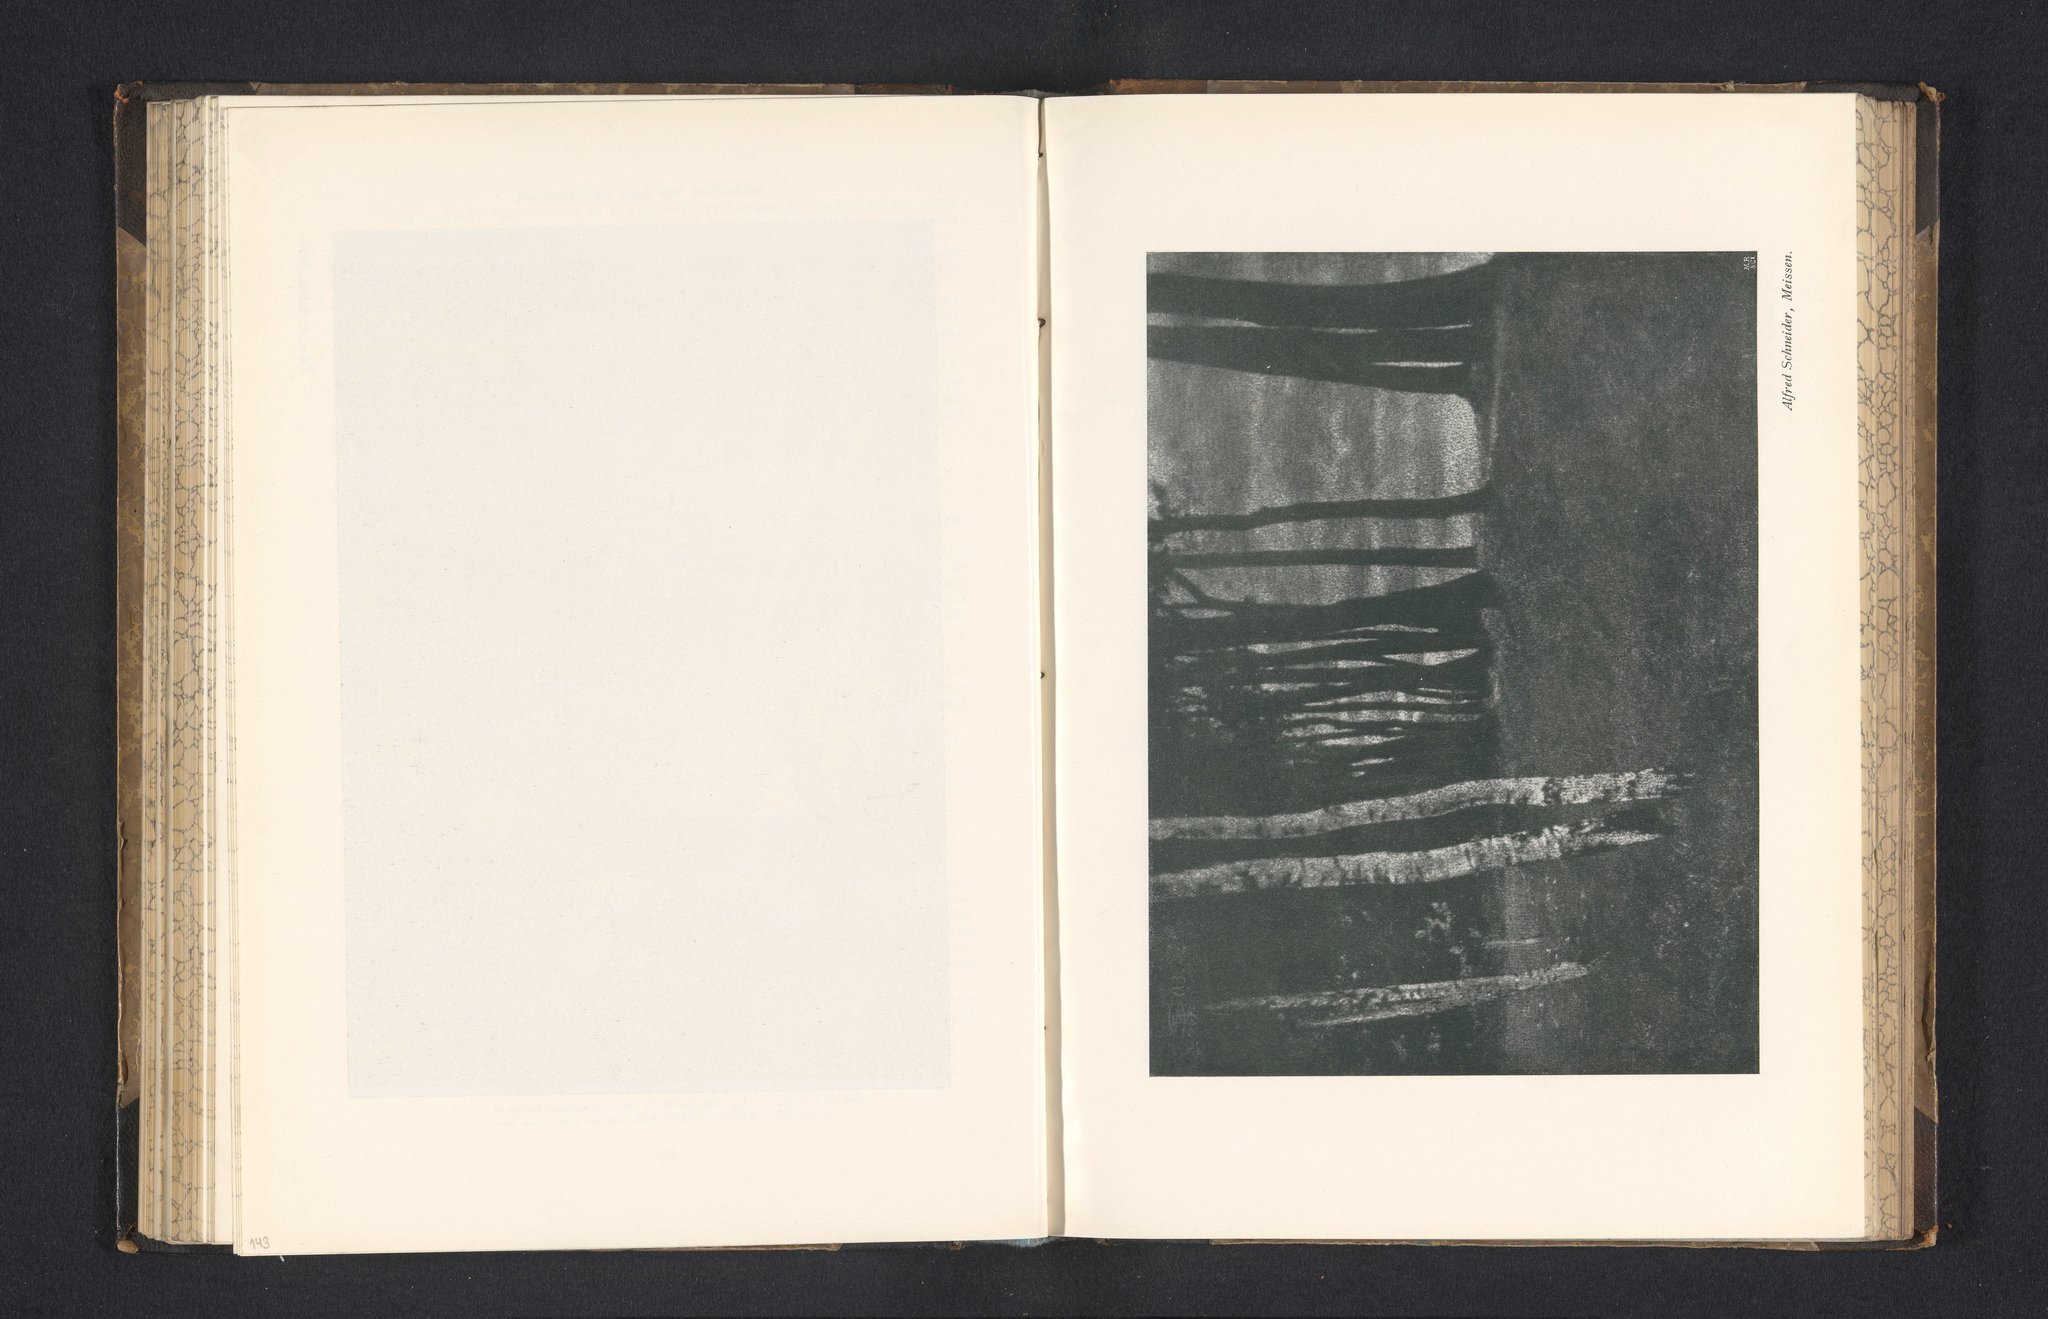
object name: page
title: Bos, met berken op de voorgrond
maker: alfred schneider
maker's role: fotograaf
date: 1898-1903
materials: paper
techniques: autotype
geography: berlin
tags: forest, wood, trees: birch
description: Prent op tweede ongenummerde pagina na pagina 234.